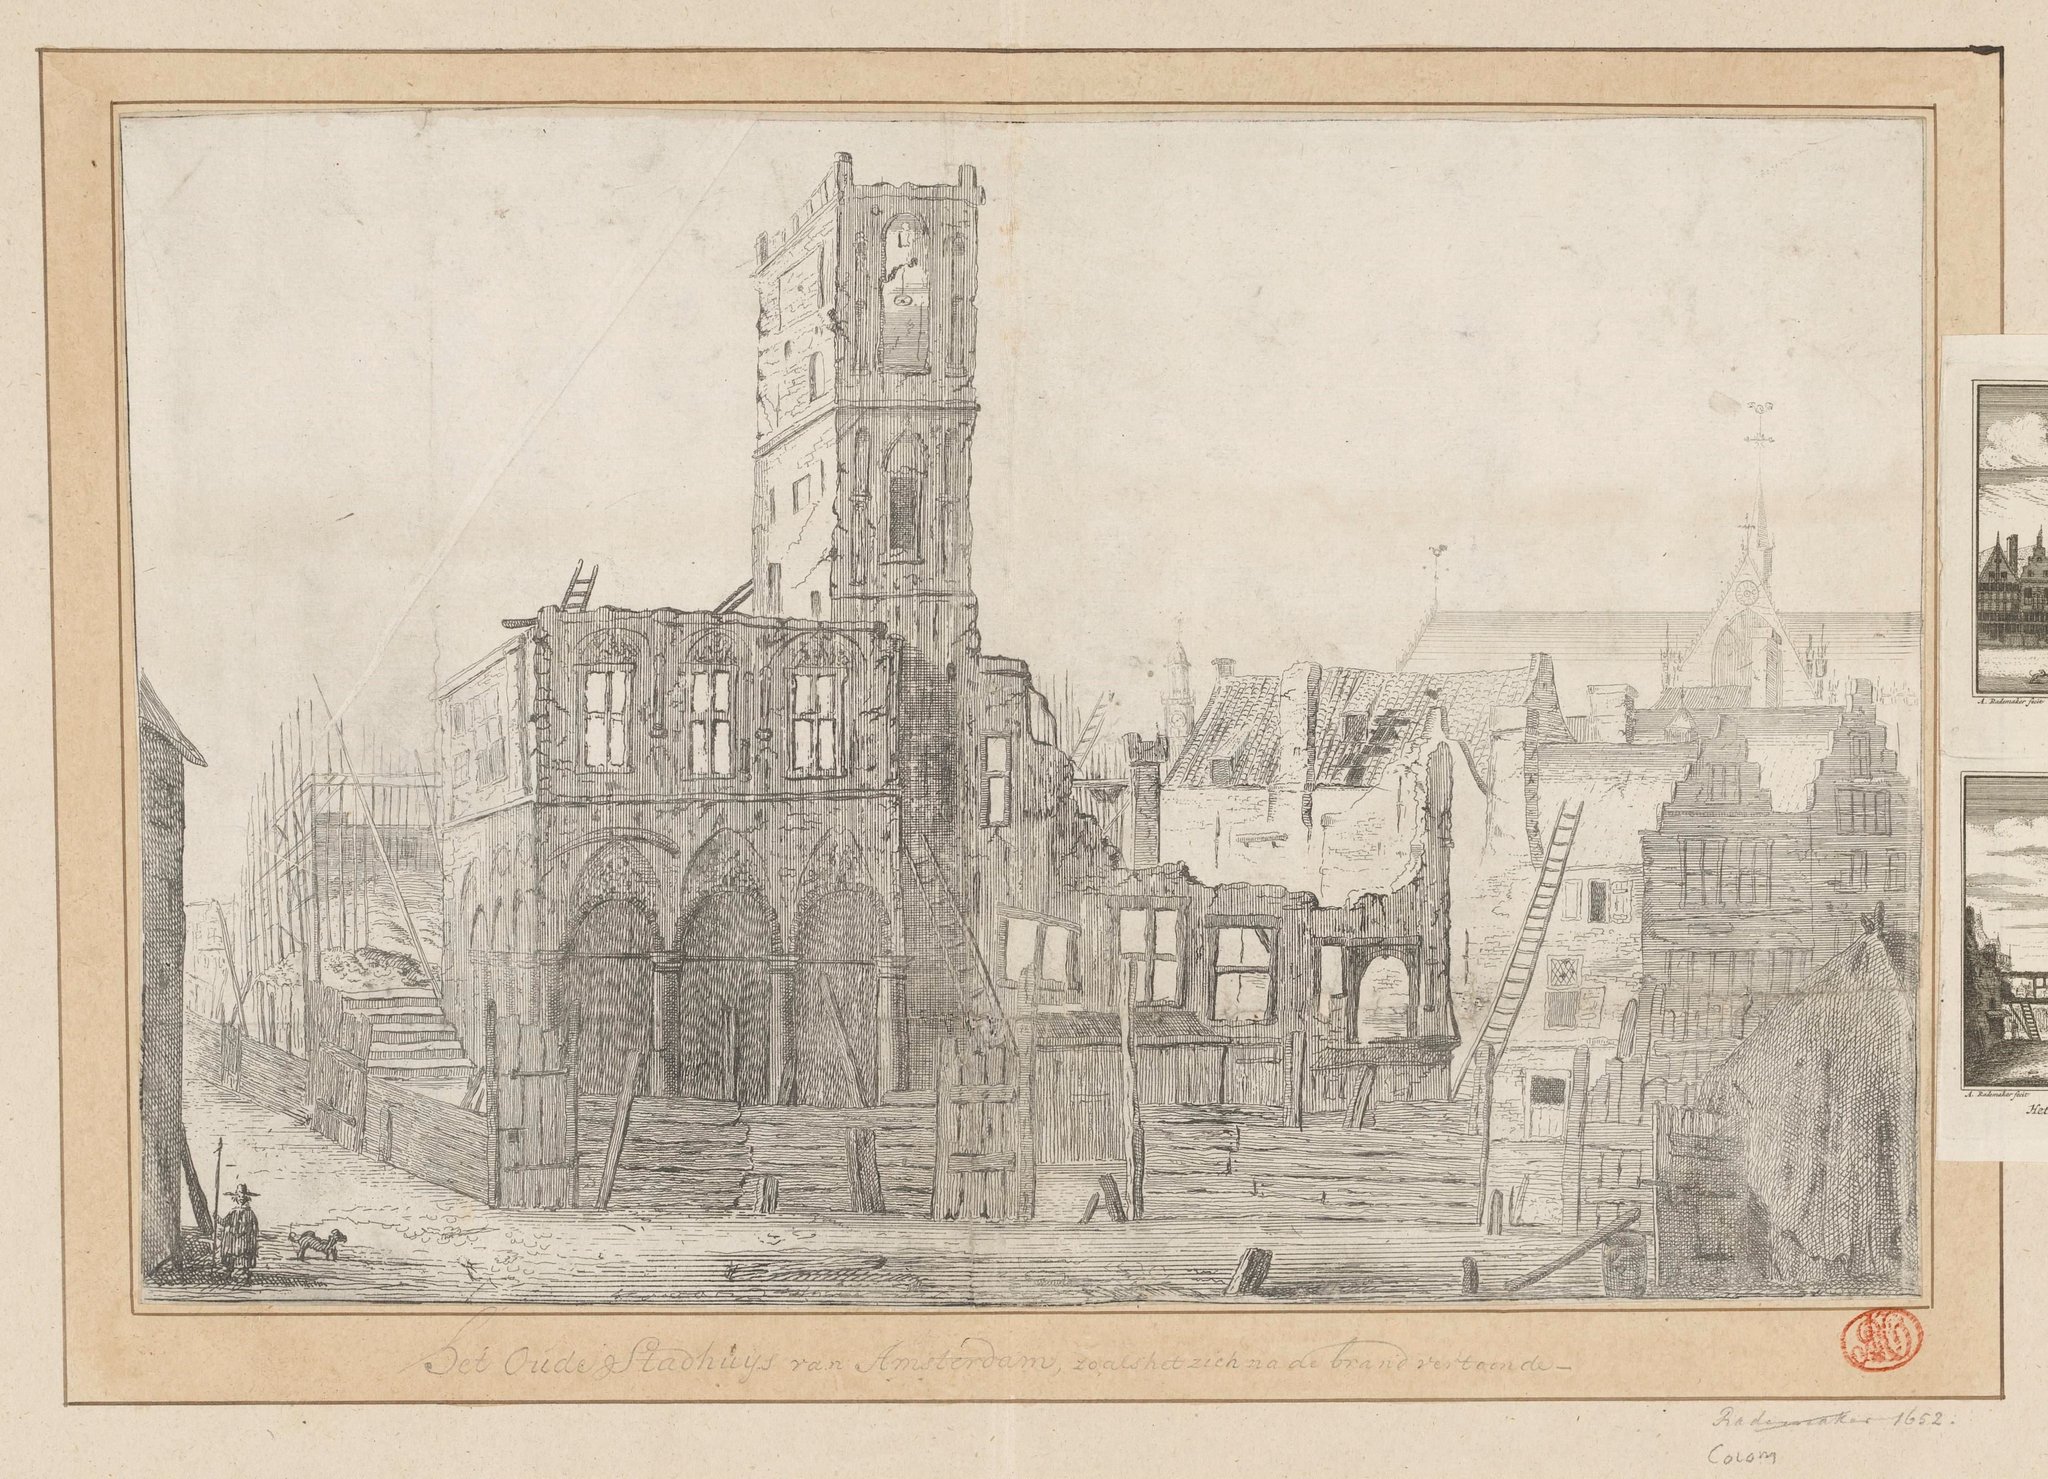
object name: print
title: Ruïne van het afgebrande Oude Stadhuis van Amsterdam, 1652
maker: arnold colom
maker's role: print maker, publisher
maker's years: 1623-1668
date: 1652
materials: ink, paper, pencil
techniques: brush, etching, pen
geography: amsterdam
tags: ruin of a building ~ architecture, church (exterior), townhall, historical events and situations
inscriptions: collector's mark: Lugt 195, inscription: ‘Het Oude Stadhuijs van Amsterdam, zo als het zich na de brand vertoonde’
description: De ruïne van het Oude Stadhuis van Amsterdam na de brand van 7 juli 1652. Met hier en daar ladders tegen de gevel, links een wachter met hond. Op de achtergrond rechts de Nieuwe Kerk.